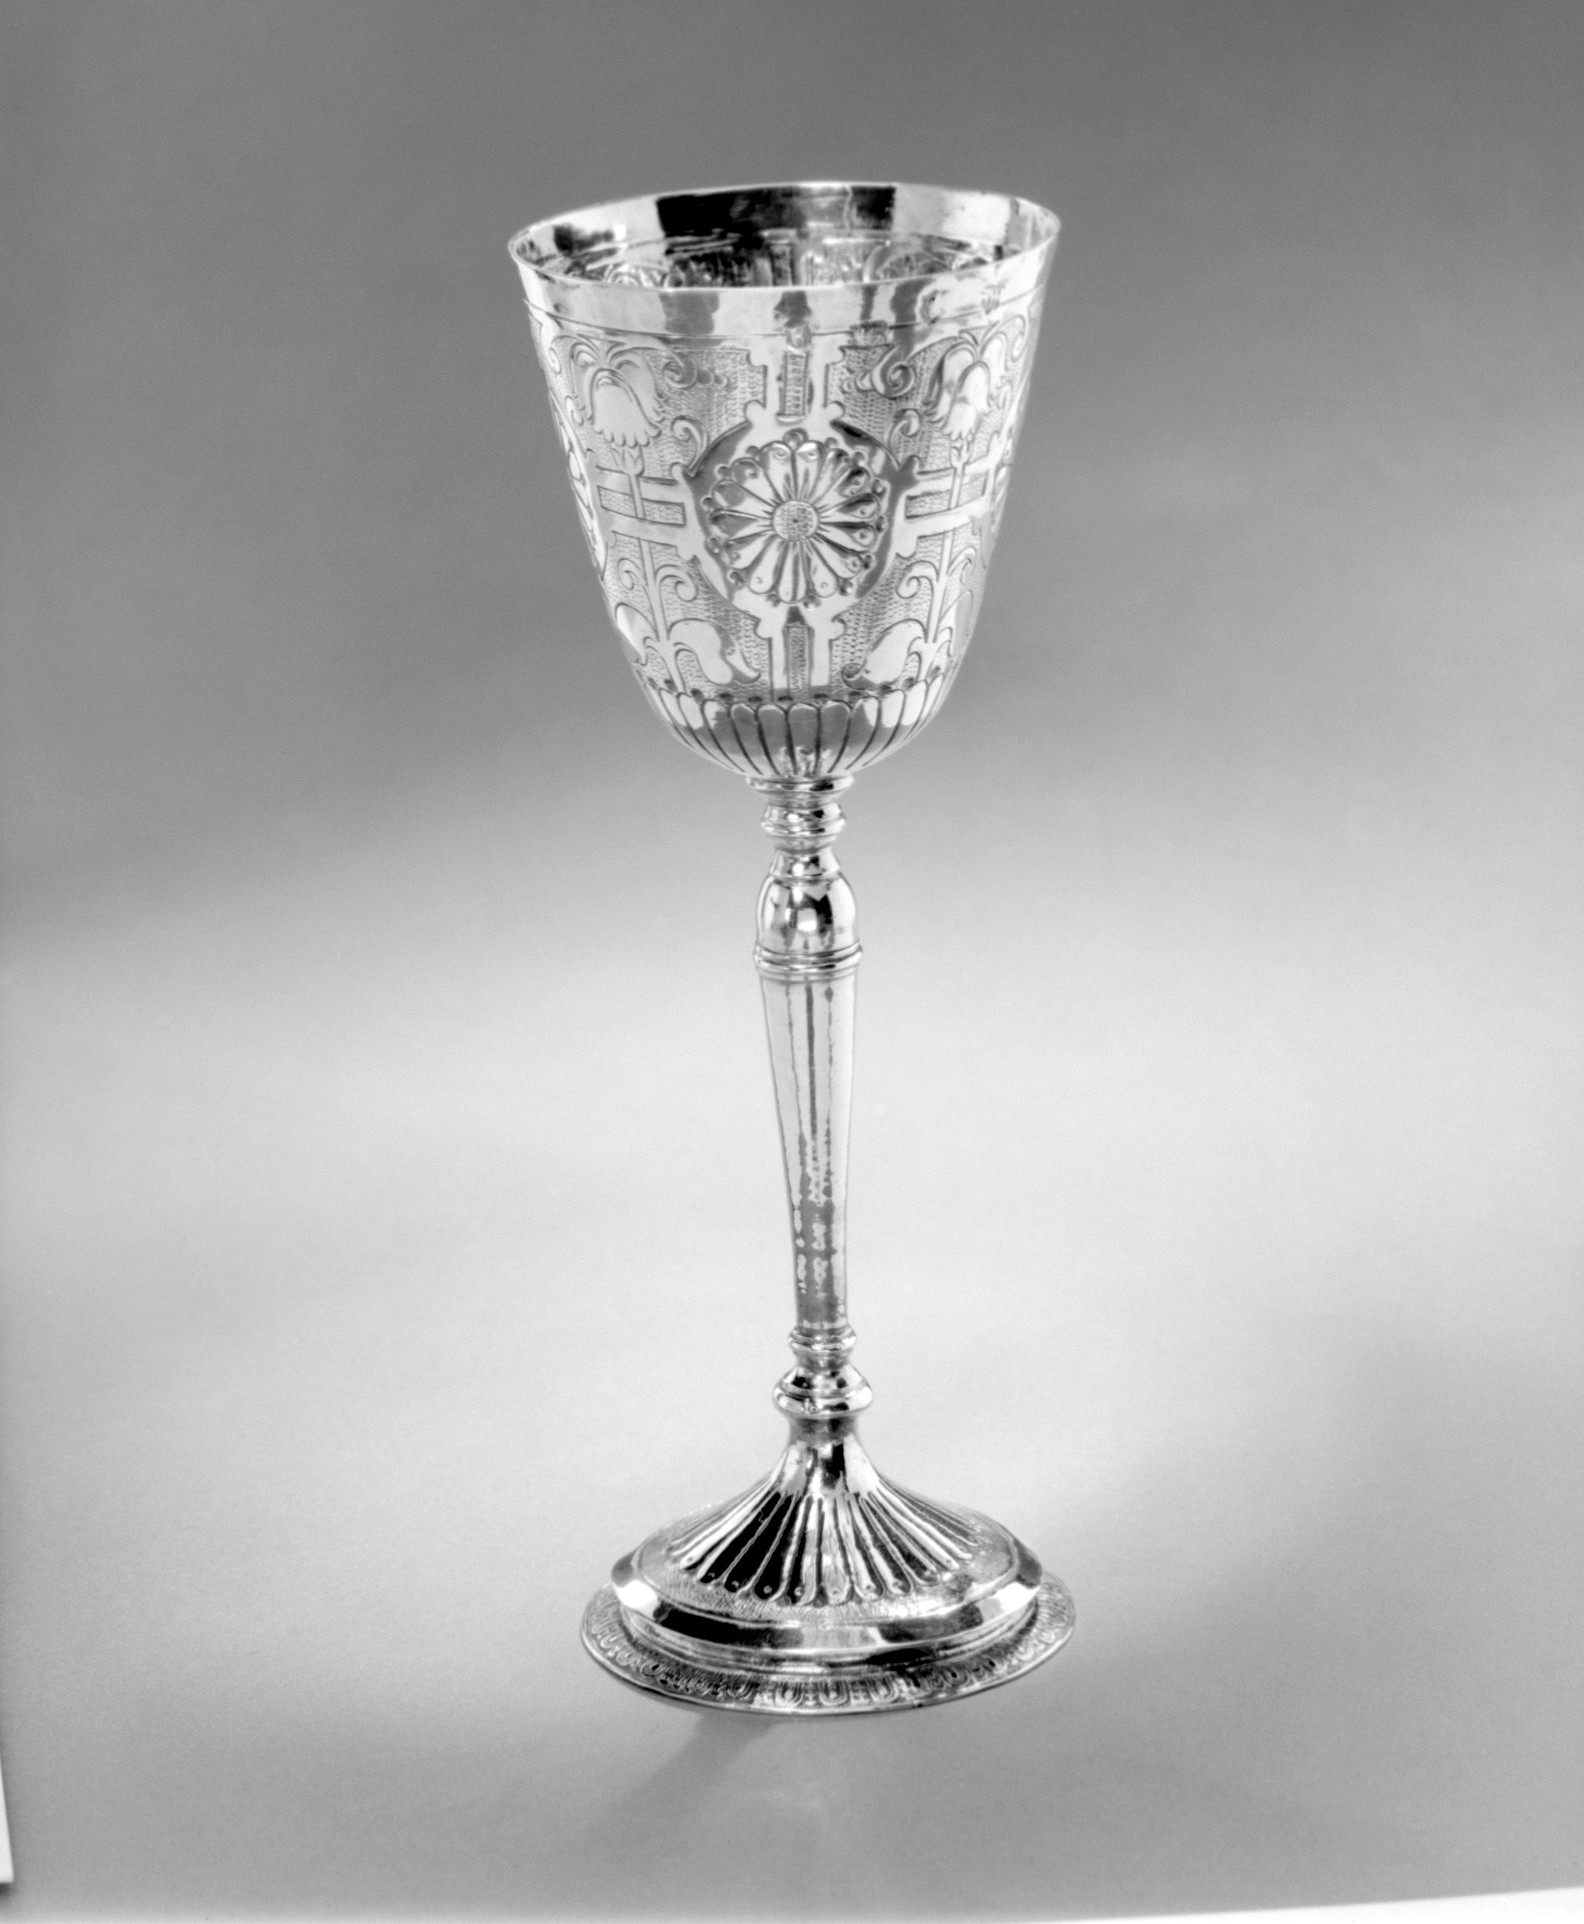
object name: wine cup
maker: r. w.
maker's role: maker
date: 1607-1608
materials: silver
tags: flowers